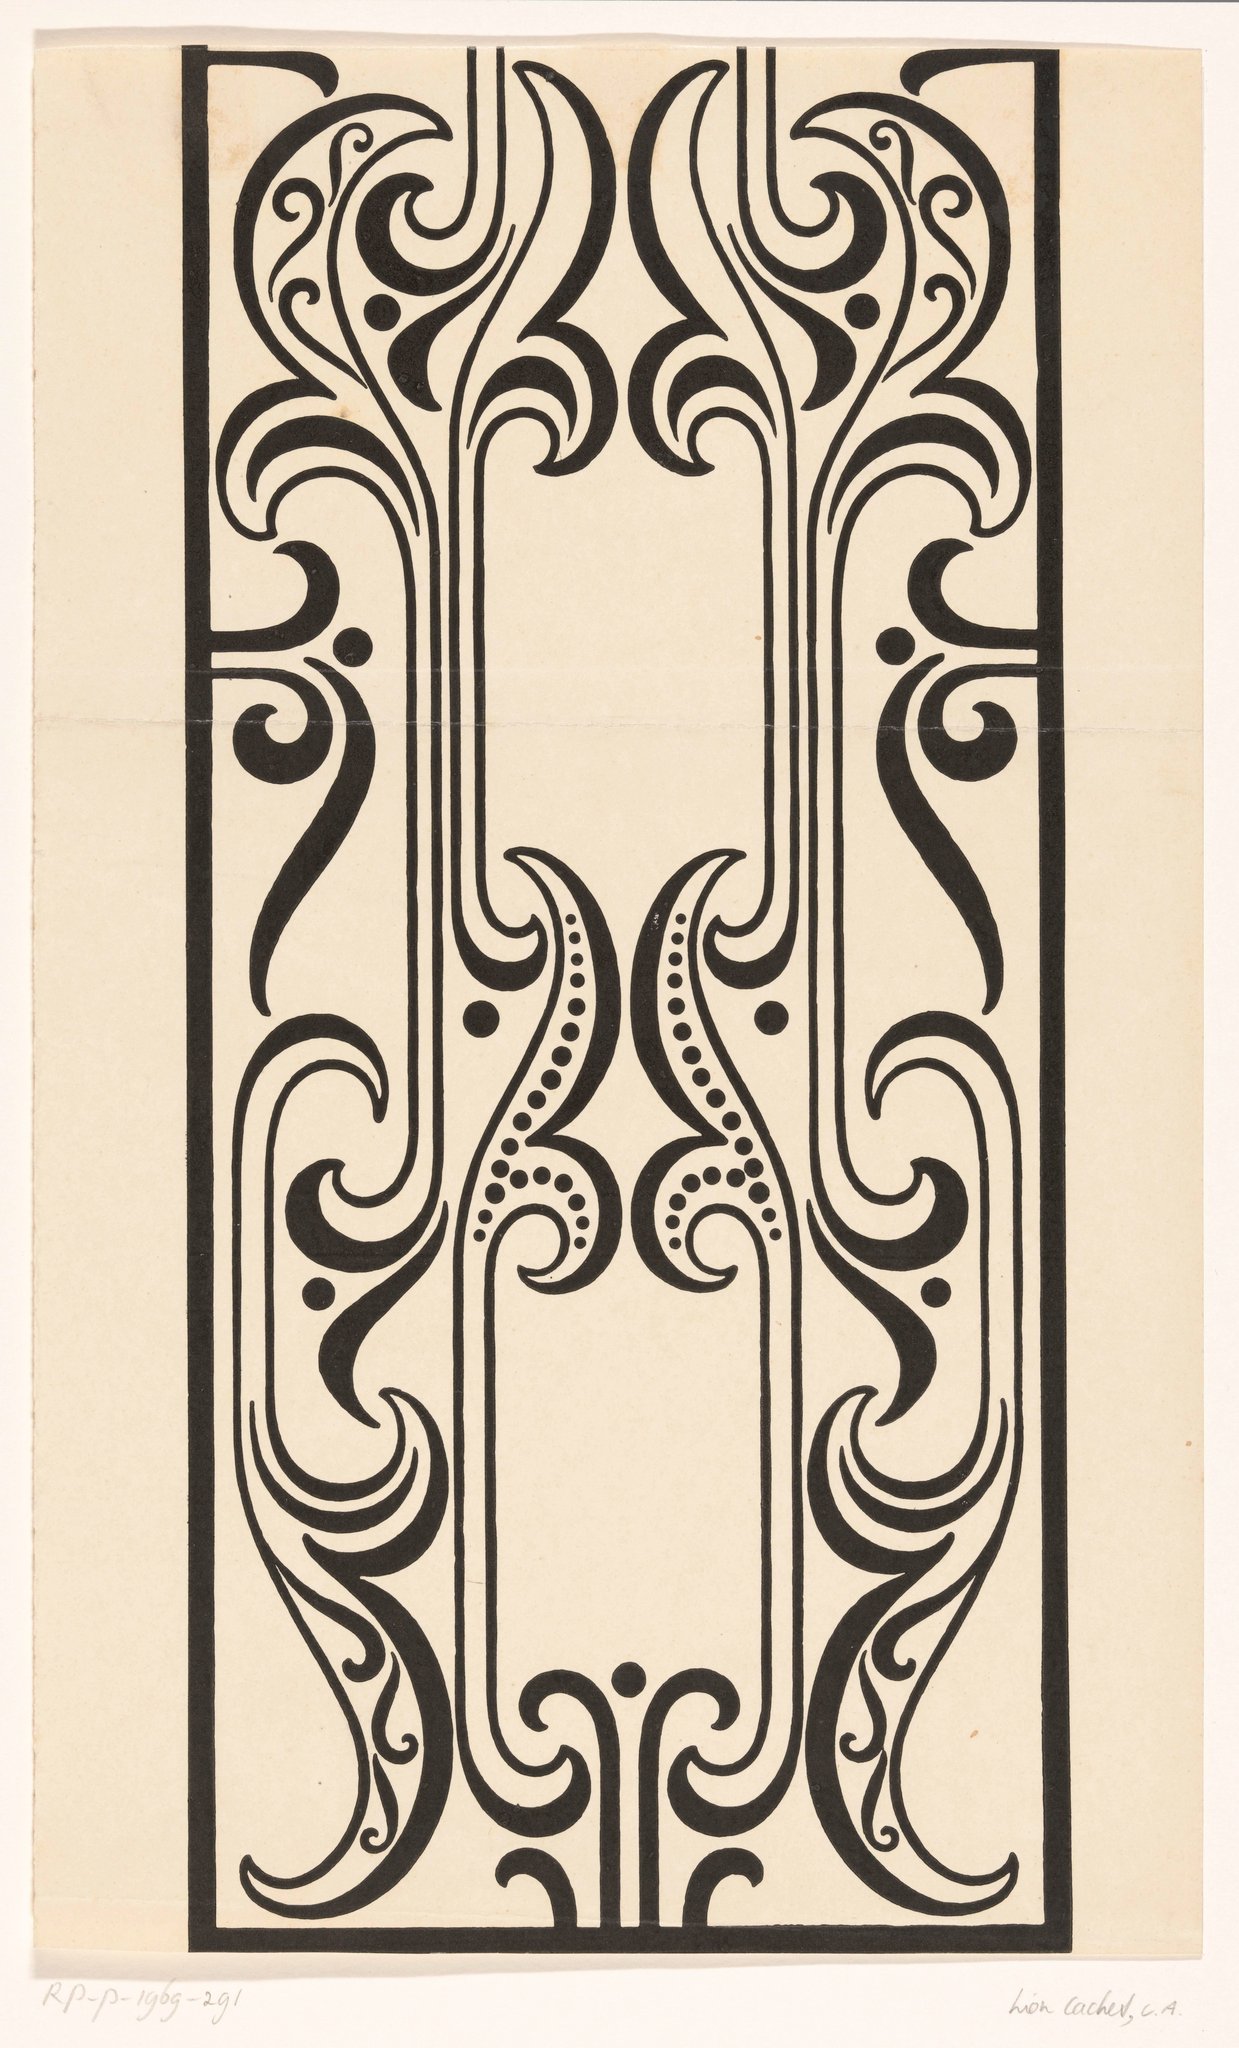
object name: print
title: Siermotief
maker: carel adolph lion cachet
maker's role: draughtsman, print maker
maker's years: 1864-1945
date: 1874-1945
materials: paper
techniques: printing block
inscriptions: collector's mark: Lugt 2228